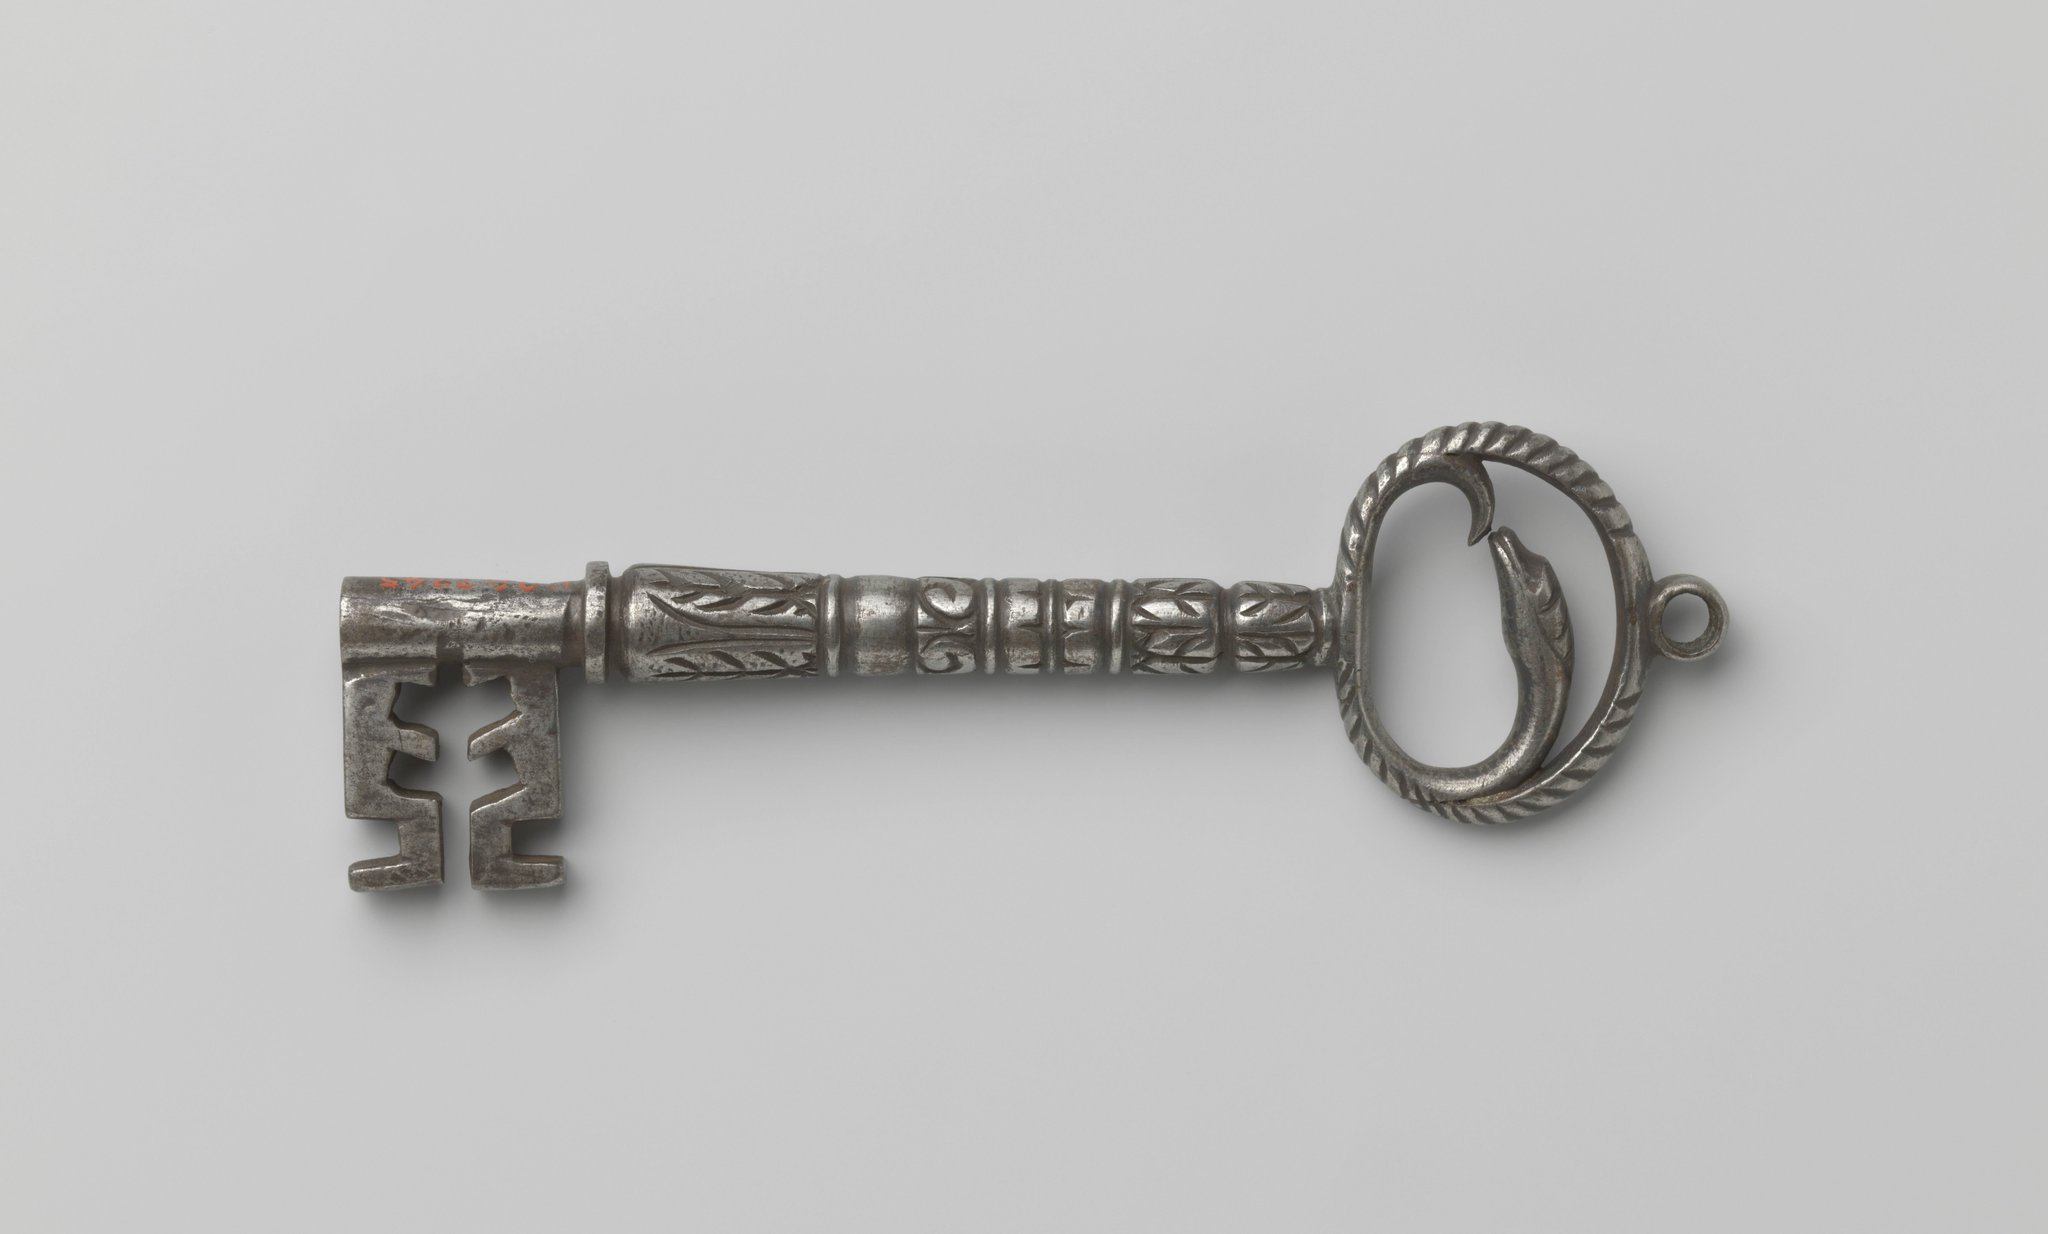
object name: key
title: Sleutel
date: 1600-1699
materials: iron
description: Sleutel met ovale greep waarin zich een slang bevindt en die bekroond wordt door een oogje. De greep is aan de buitenzijde met schuine lijnen gegroefd. De zware balustervormige schacht is met bladmotief geciseleerd. De baard is tweeledig.